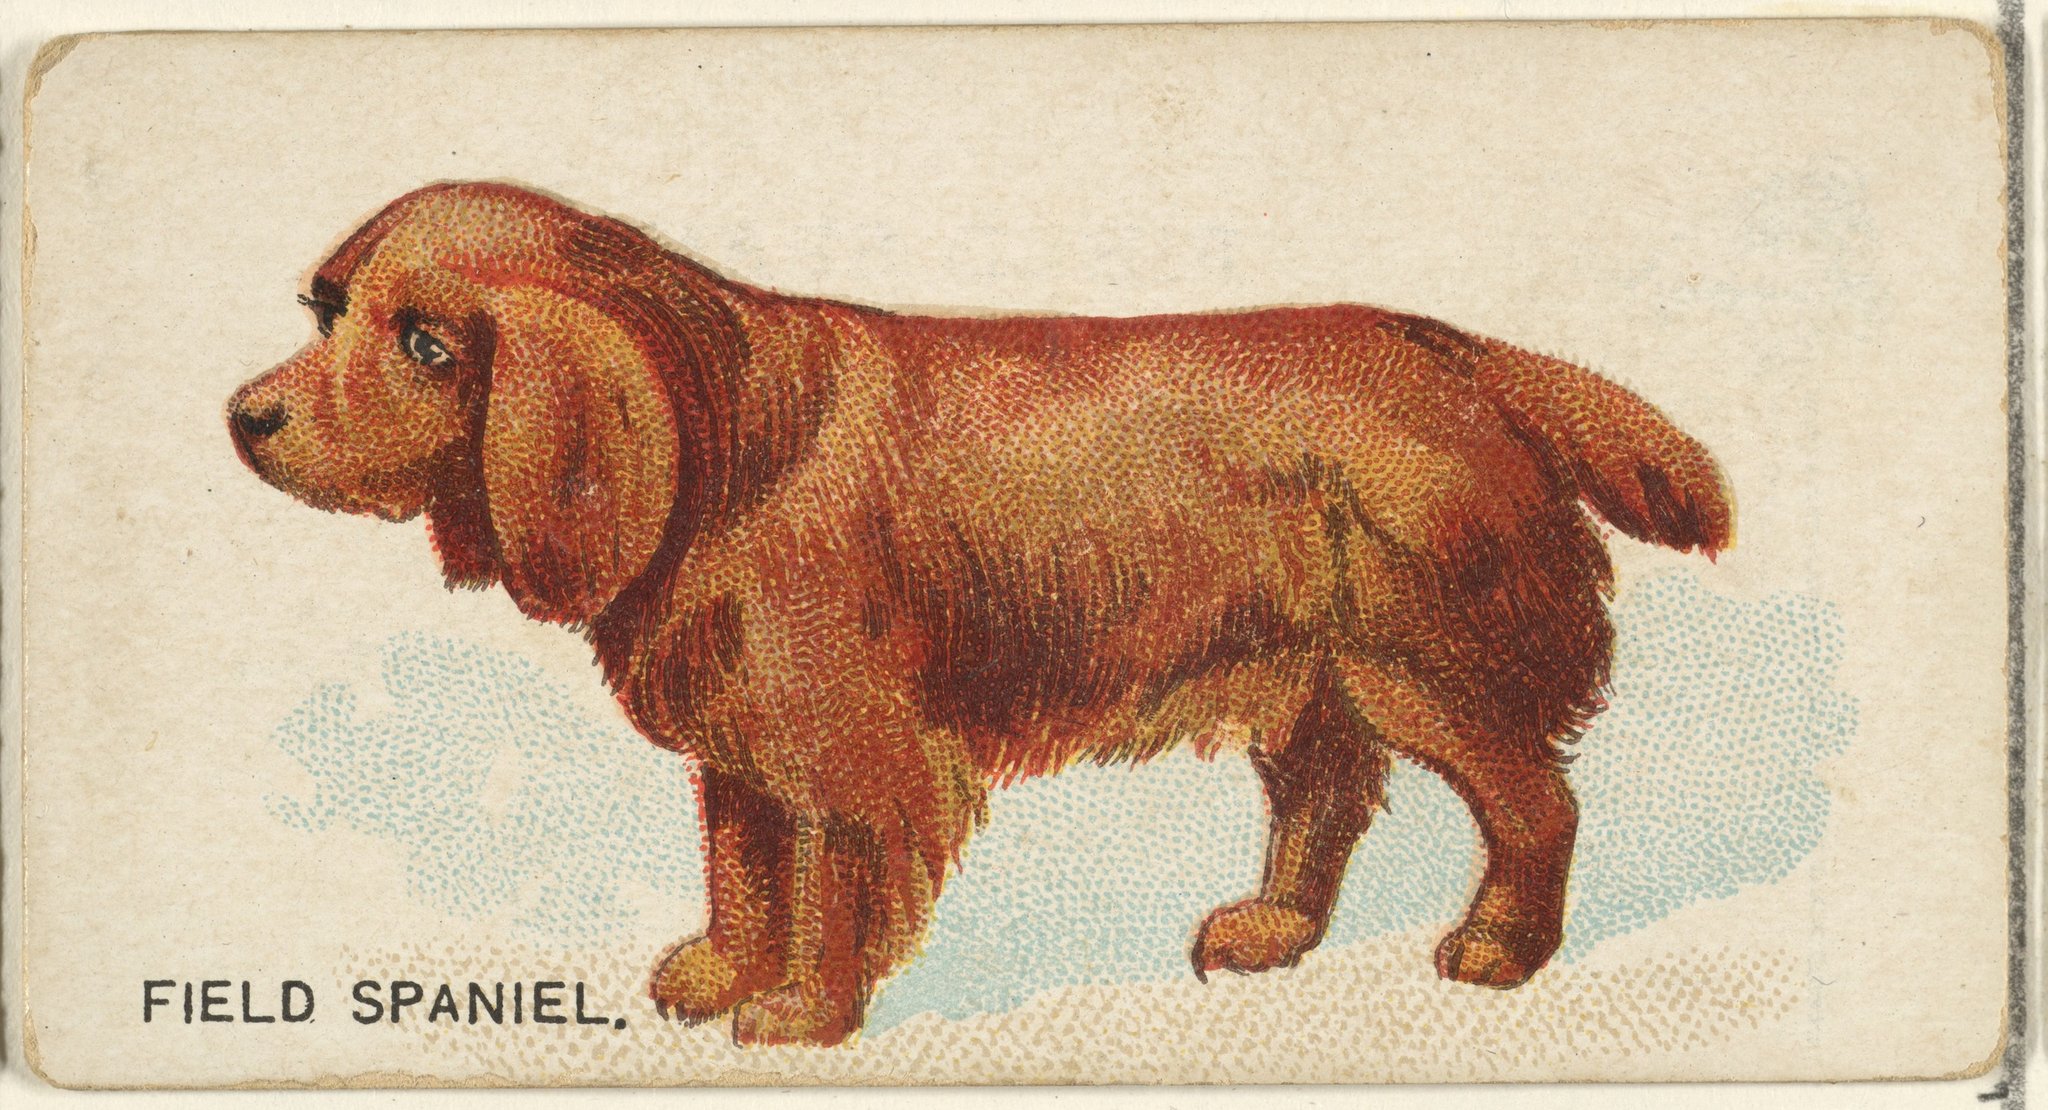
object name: print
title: Field Spaniel, from the Dogs of the World series for Old Judge Cigarettes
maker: goodwin & company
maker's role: publisher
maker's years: 1850-1950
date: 1890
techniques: color lithograph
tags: dogs